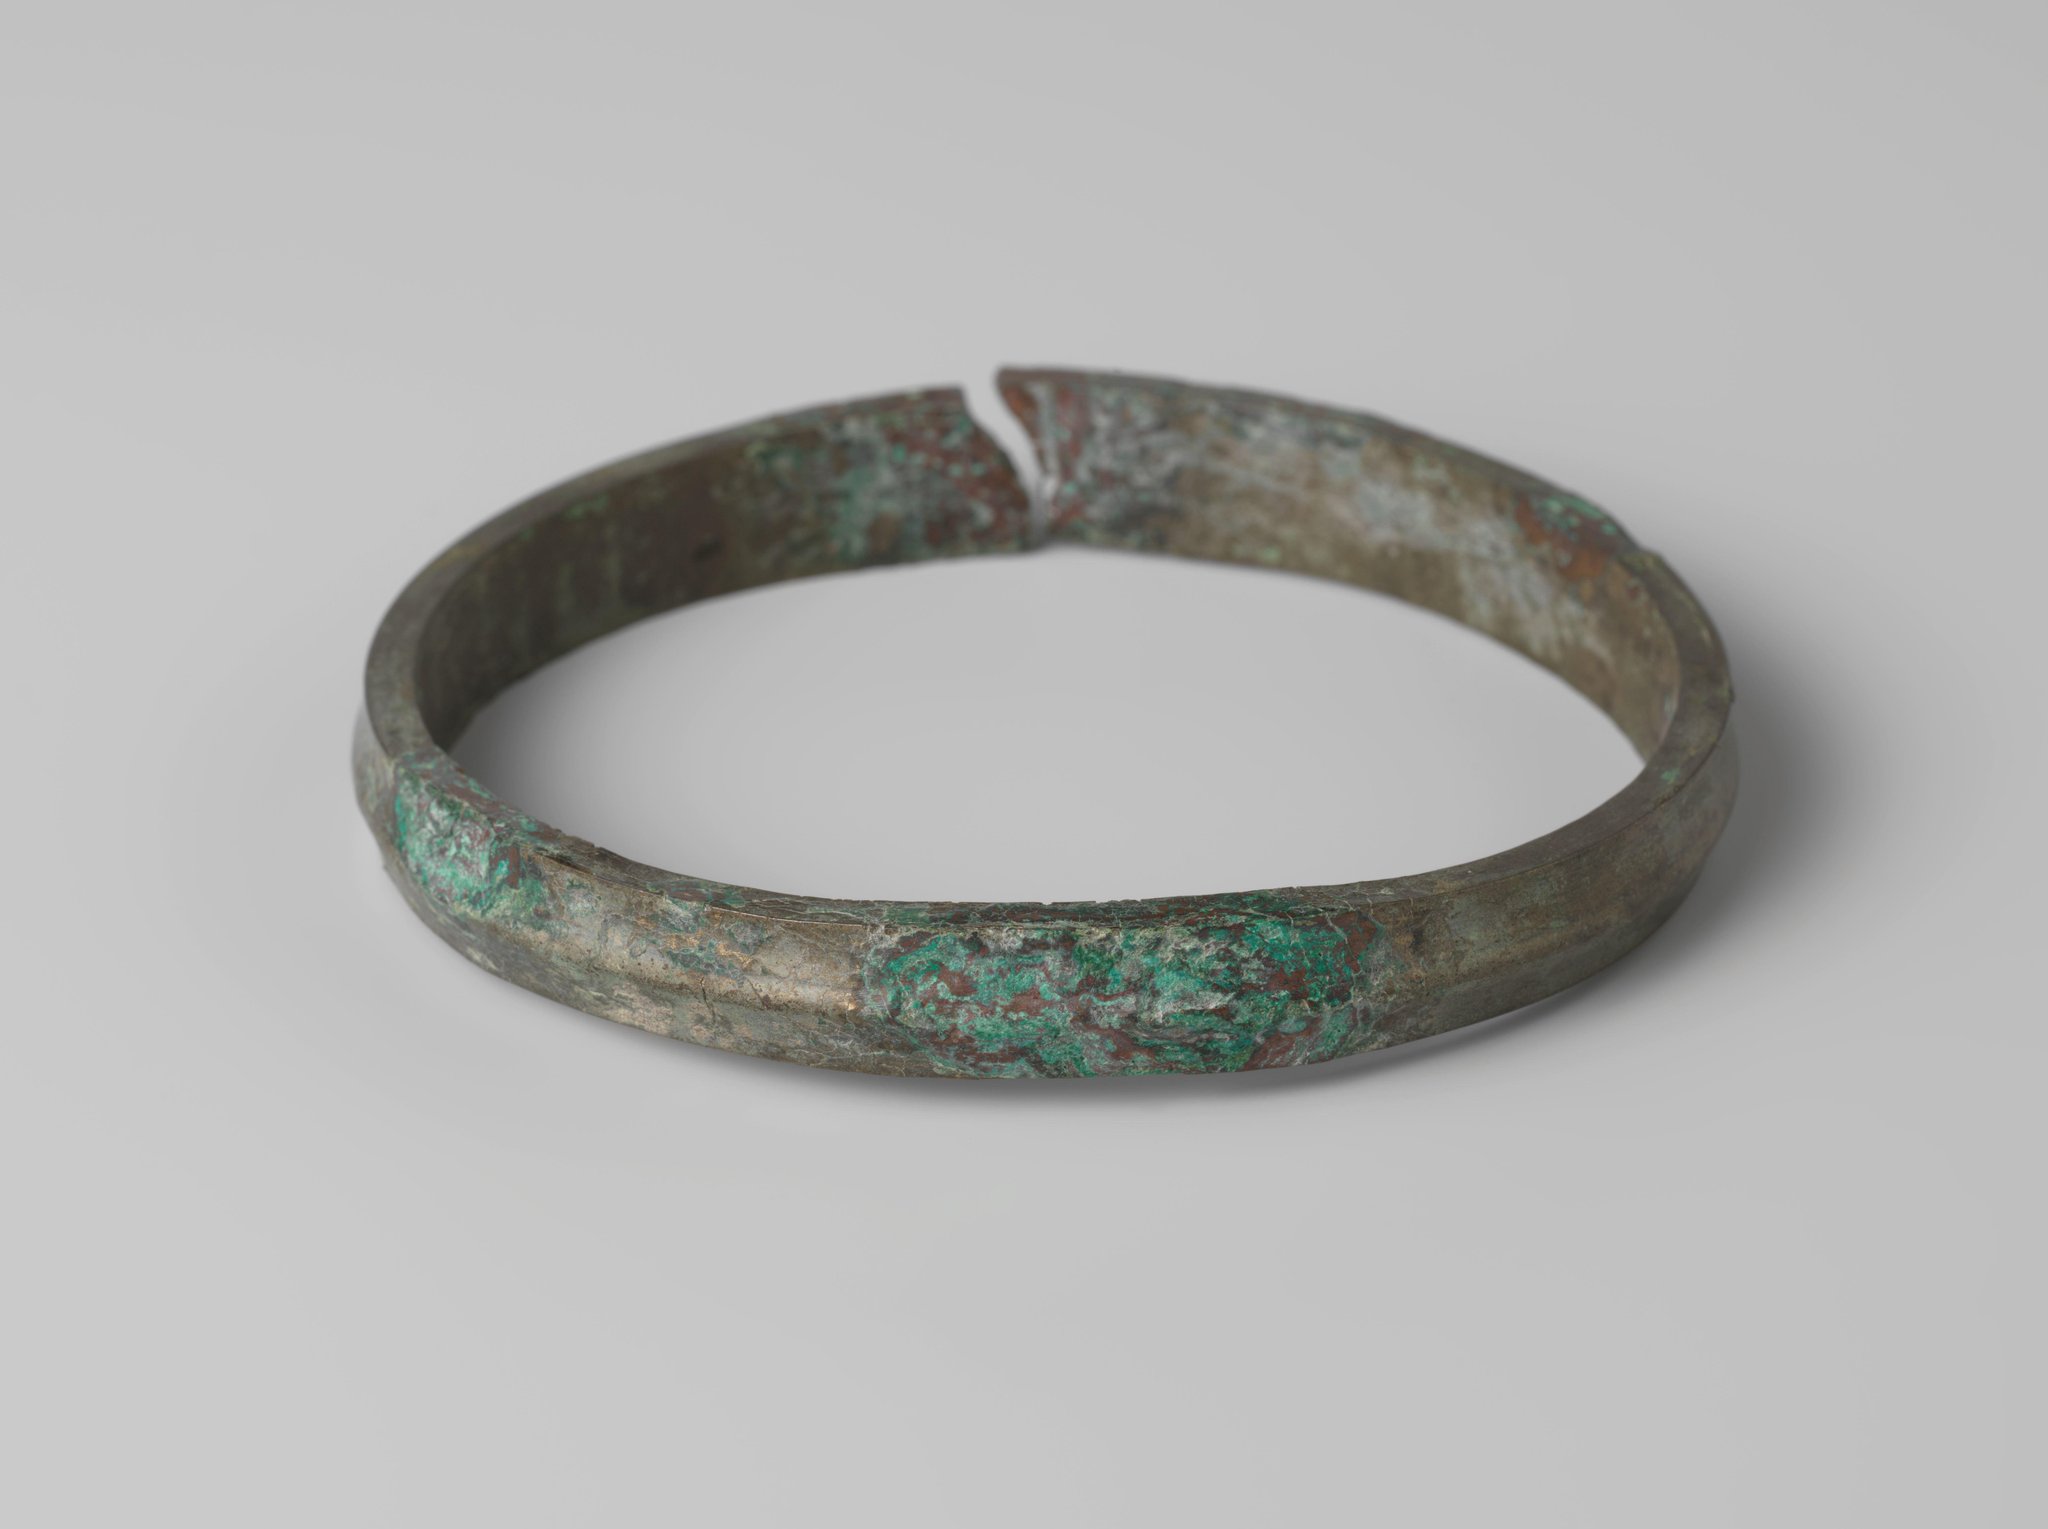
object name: anklet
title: Enkelband, zonder versiering met enkele incrustaties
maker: Anonymous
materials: bronze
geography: ban chiang